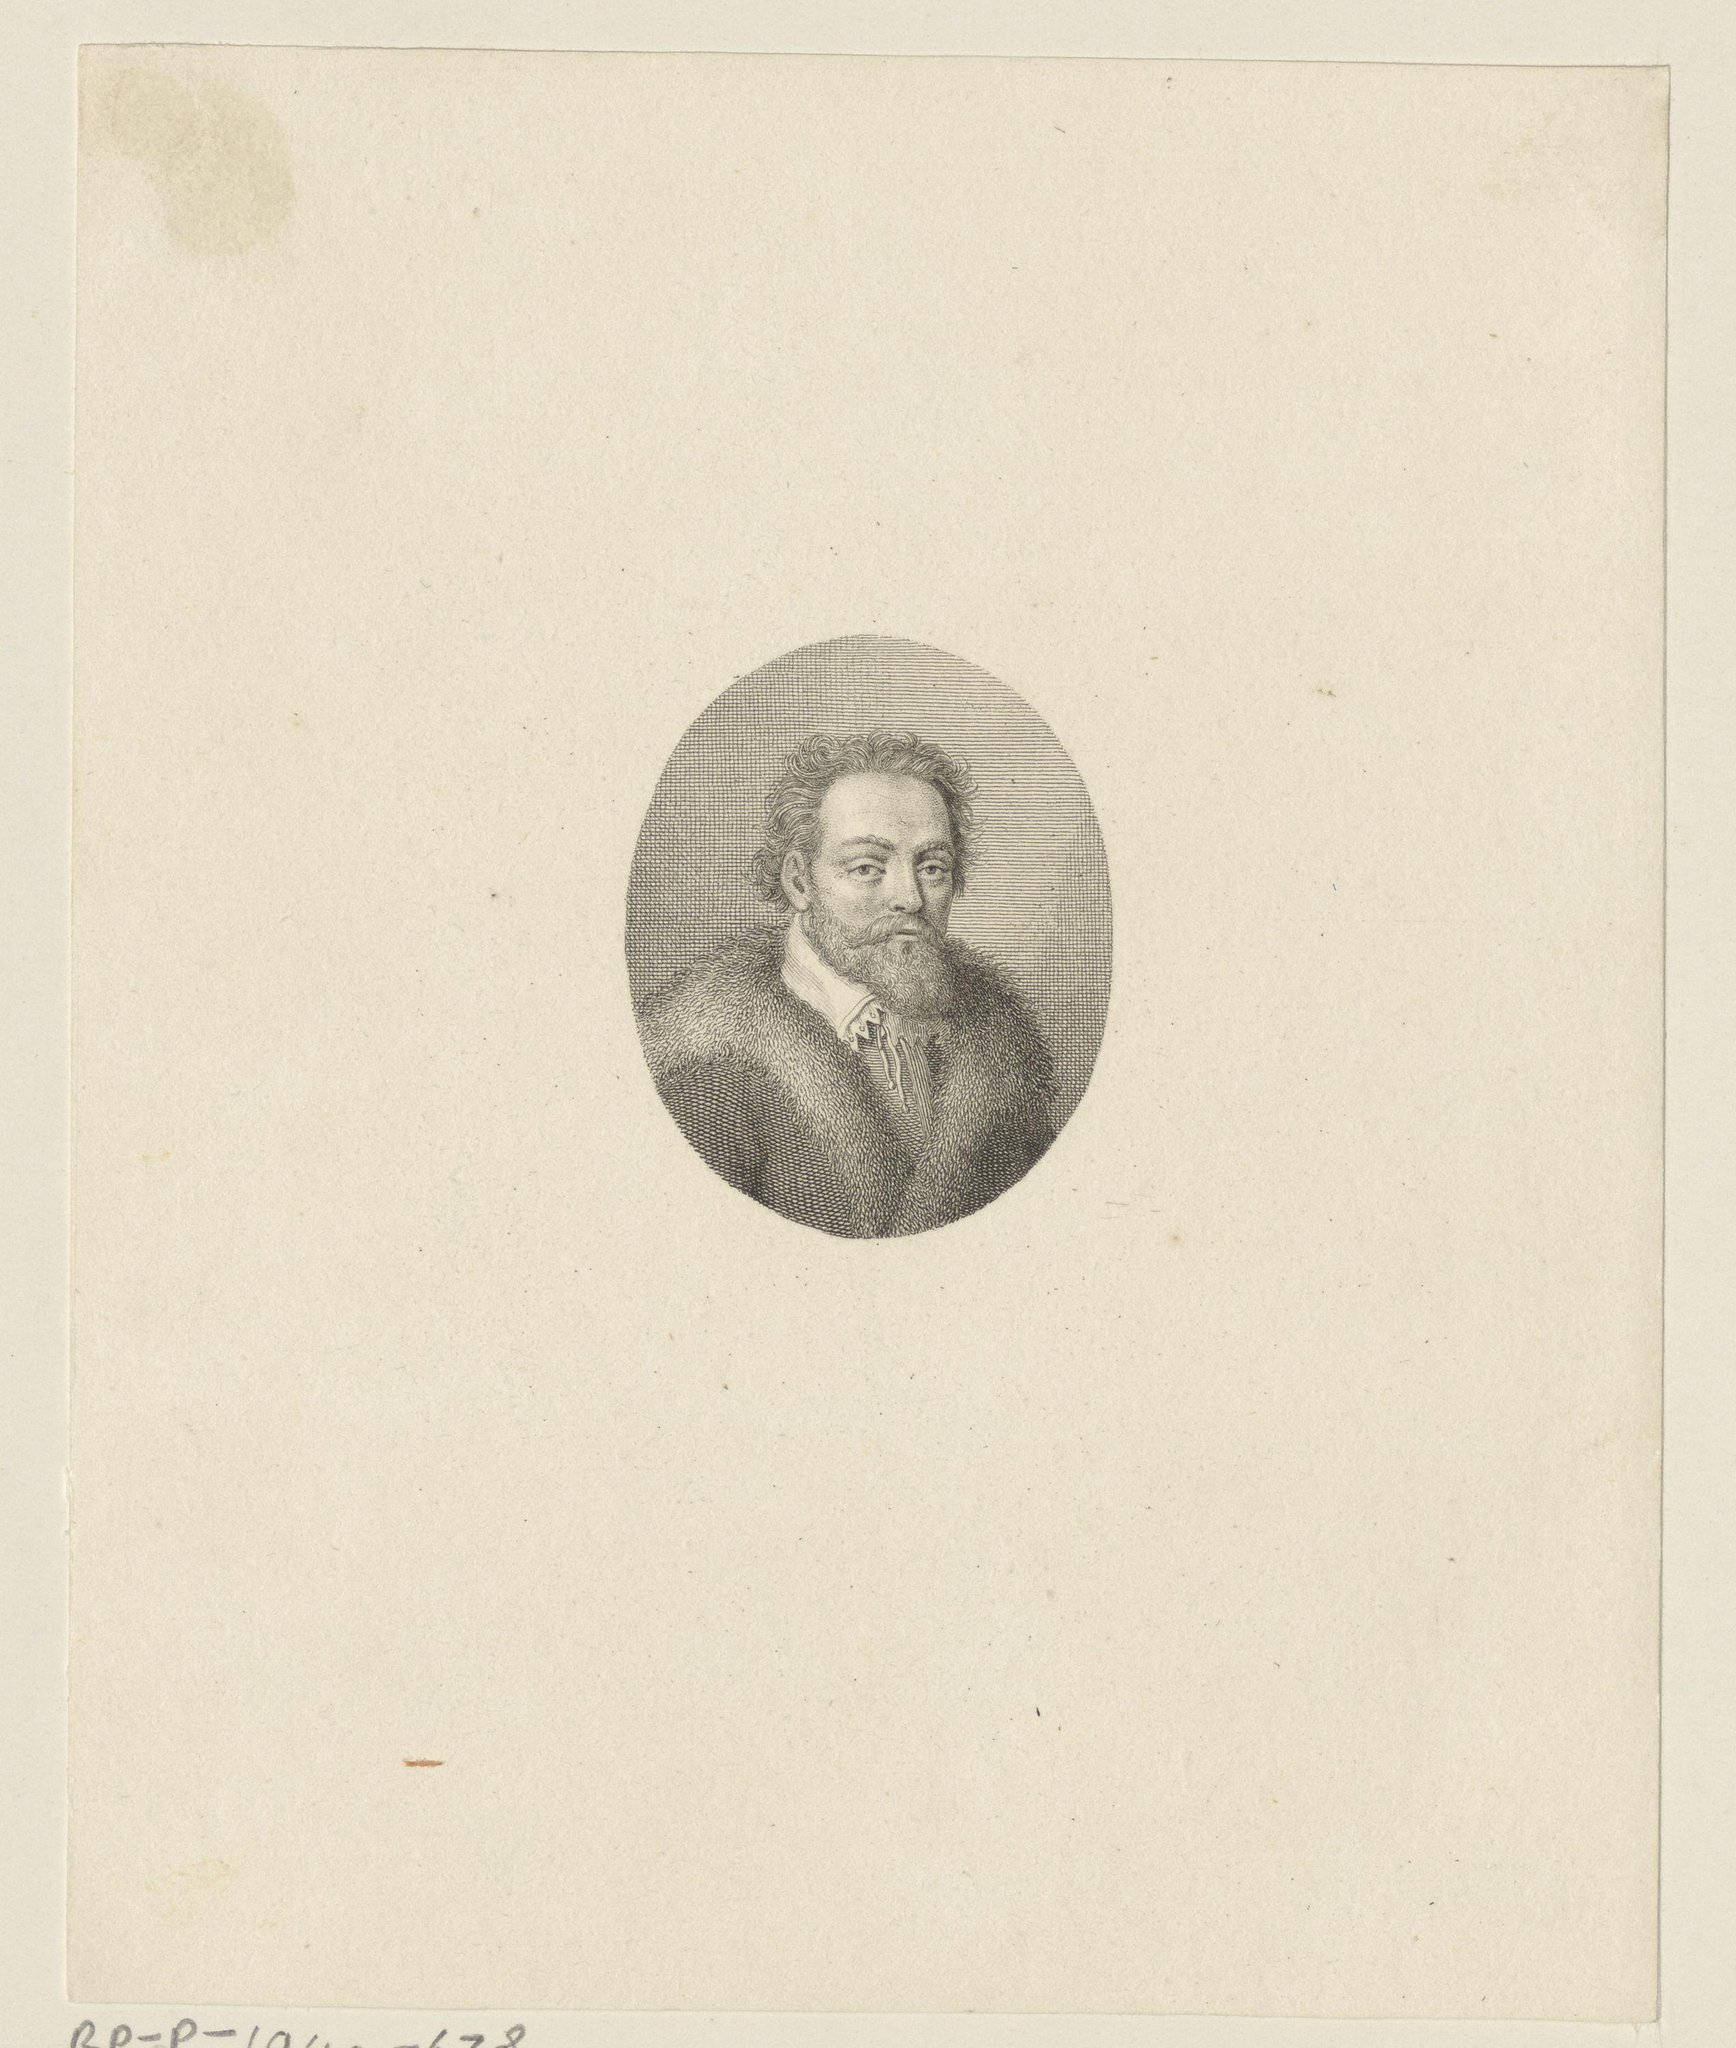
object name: print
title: Portret van Cornelis Jacobsz. Drebbel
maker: Anonymous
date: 1821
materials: paper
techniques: engraving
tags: london, print maker, cornelis jacobsz. drebbel, historical persons, portrait, self-portrait of graphic artist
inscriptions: collector's mark: Lugt 2228, collector's mark: Lugt 2760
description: Prent met tekst op recto gebruikt in: Capelle, Johannes Pieter van. Bijdragen tot de geschiedenis der wetenschappen en letteren in Nederland. Amsterdam: Johannes van der Hey, 1821, p. 65.